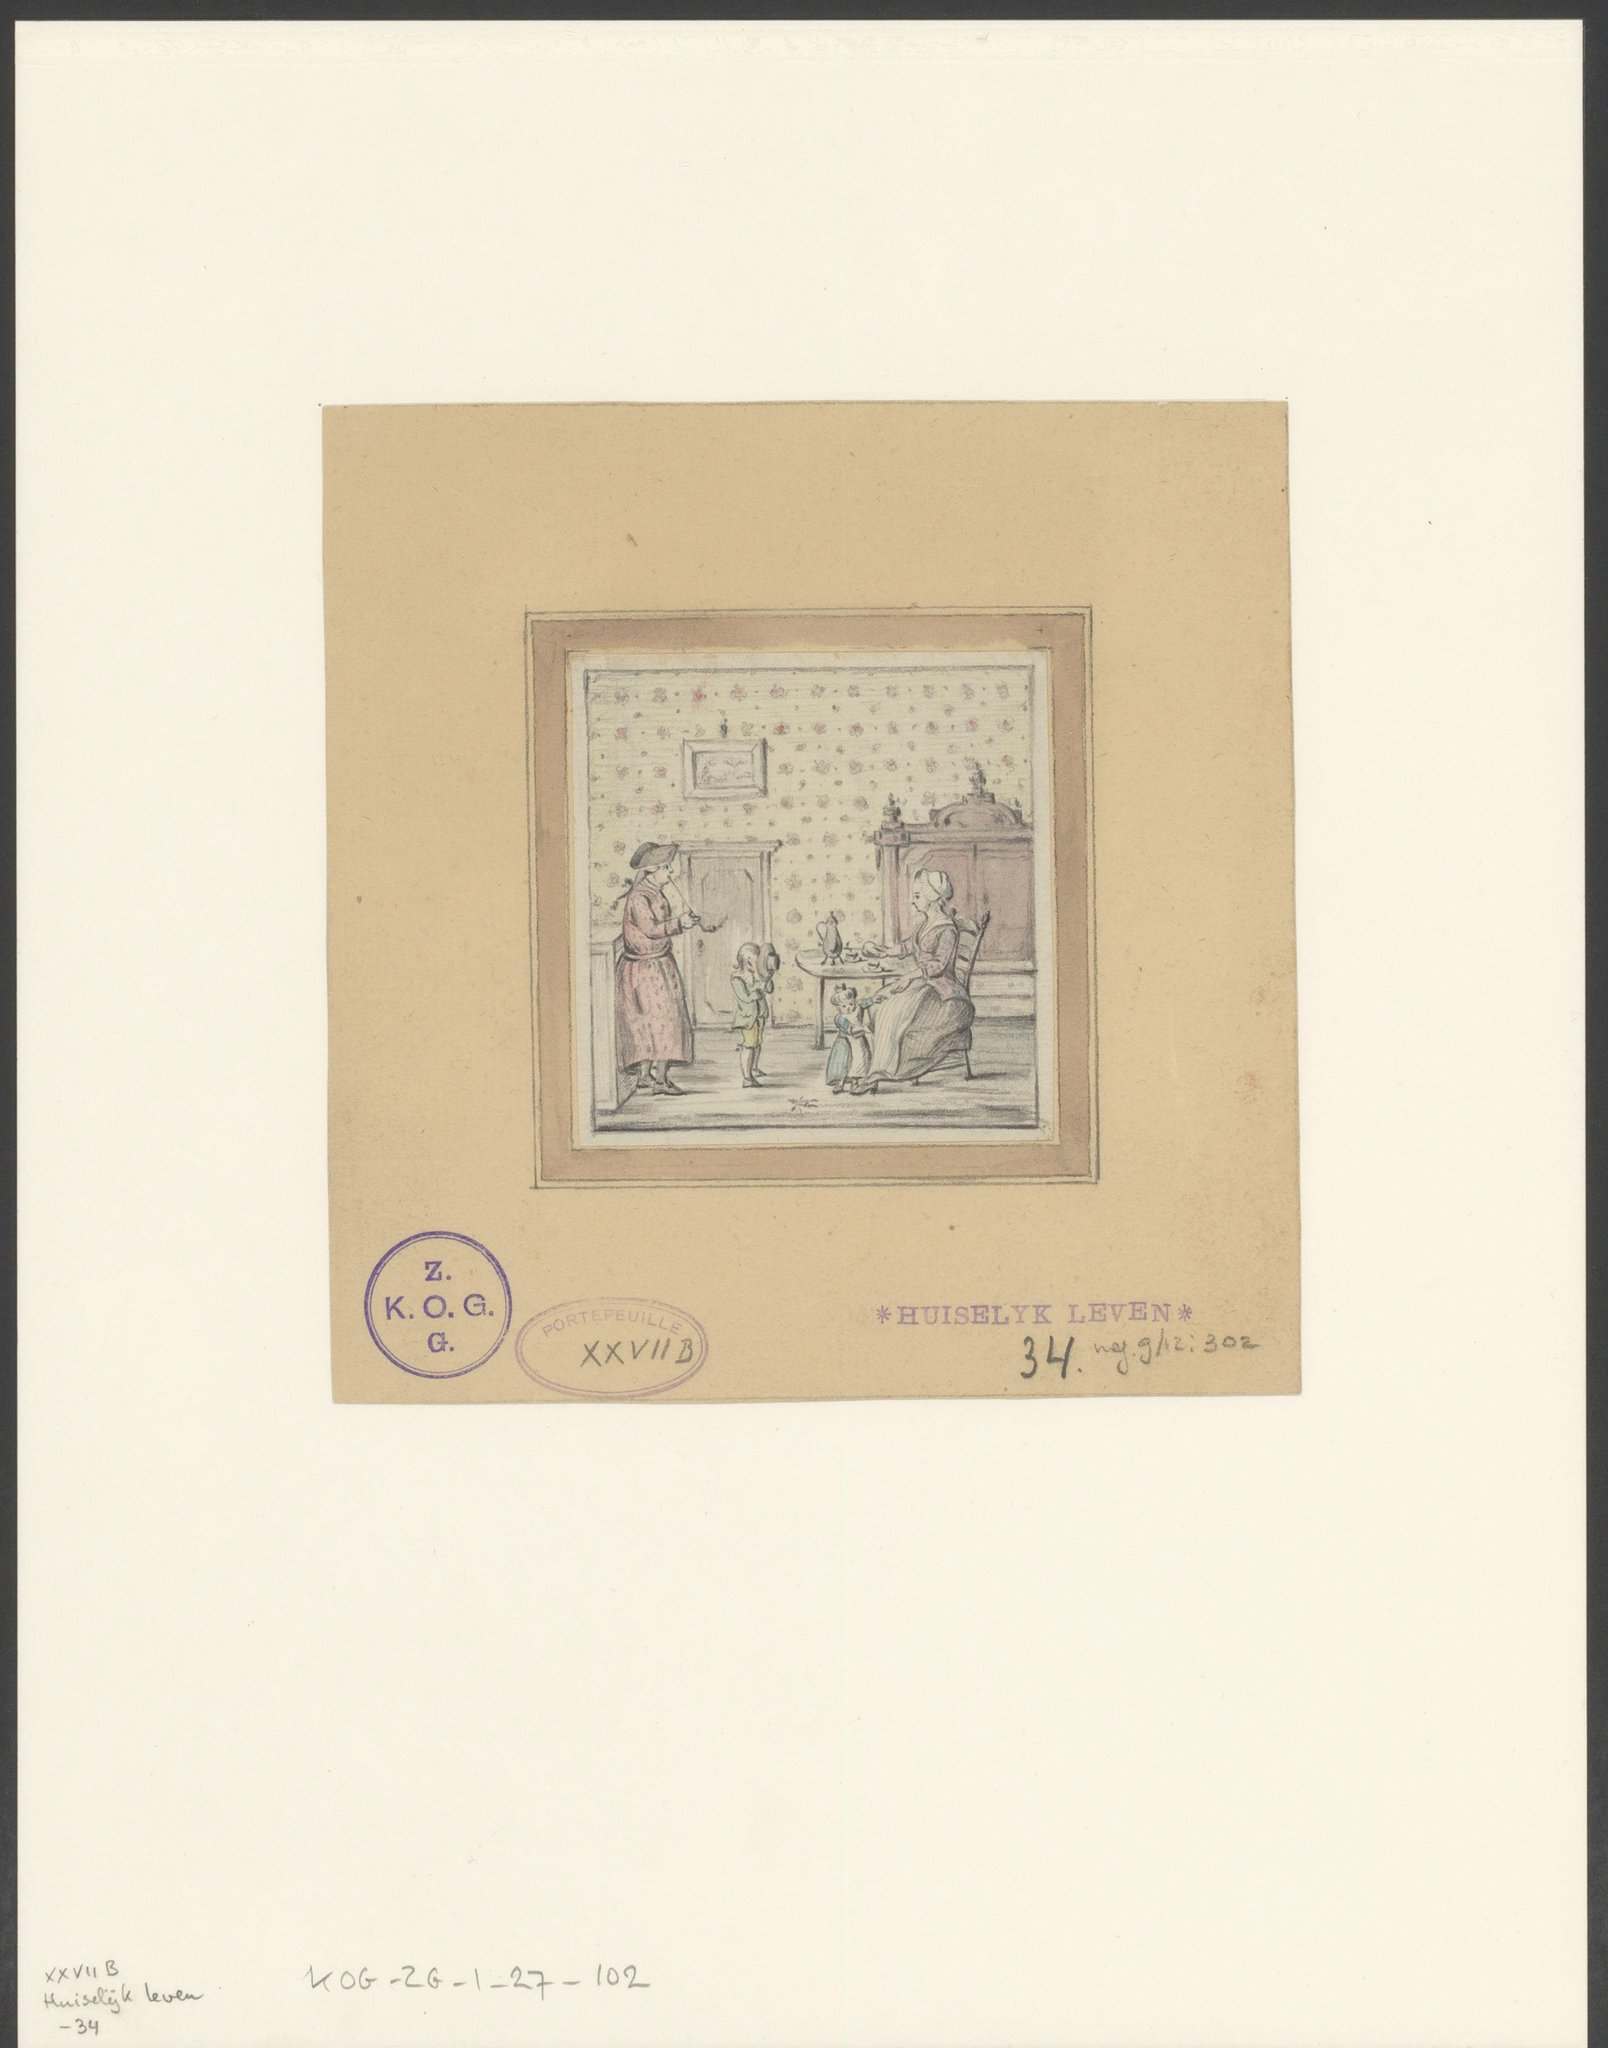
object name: drawing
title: Gezin in interieur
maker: Anonymous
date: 1725-1799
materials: paper, watercolor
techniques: brush, pen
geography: netherlands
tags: pipe ~ tobacco, communal rooms, family life at home, tea- and coffee-service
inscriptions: collector's mark, collector's mark: Lugt 1641